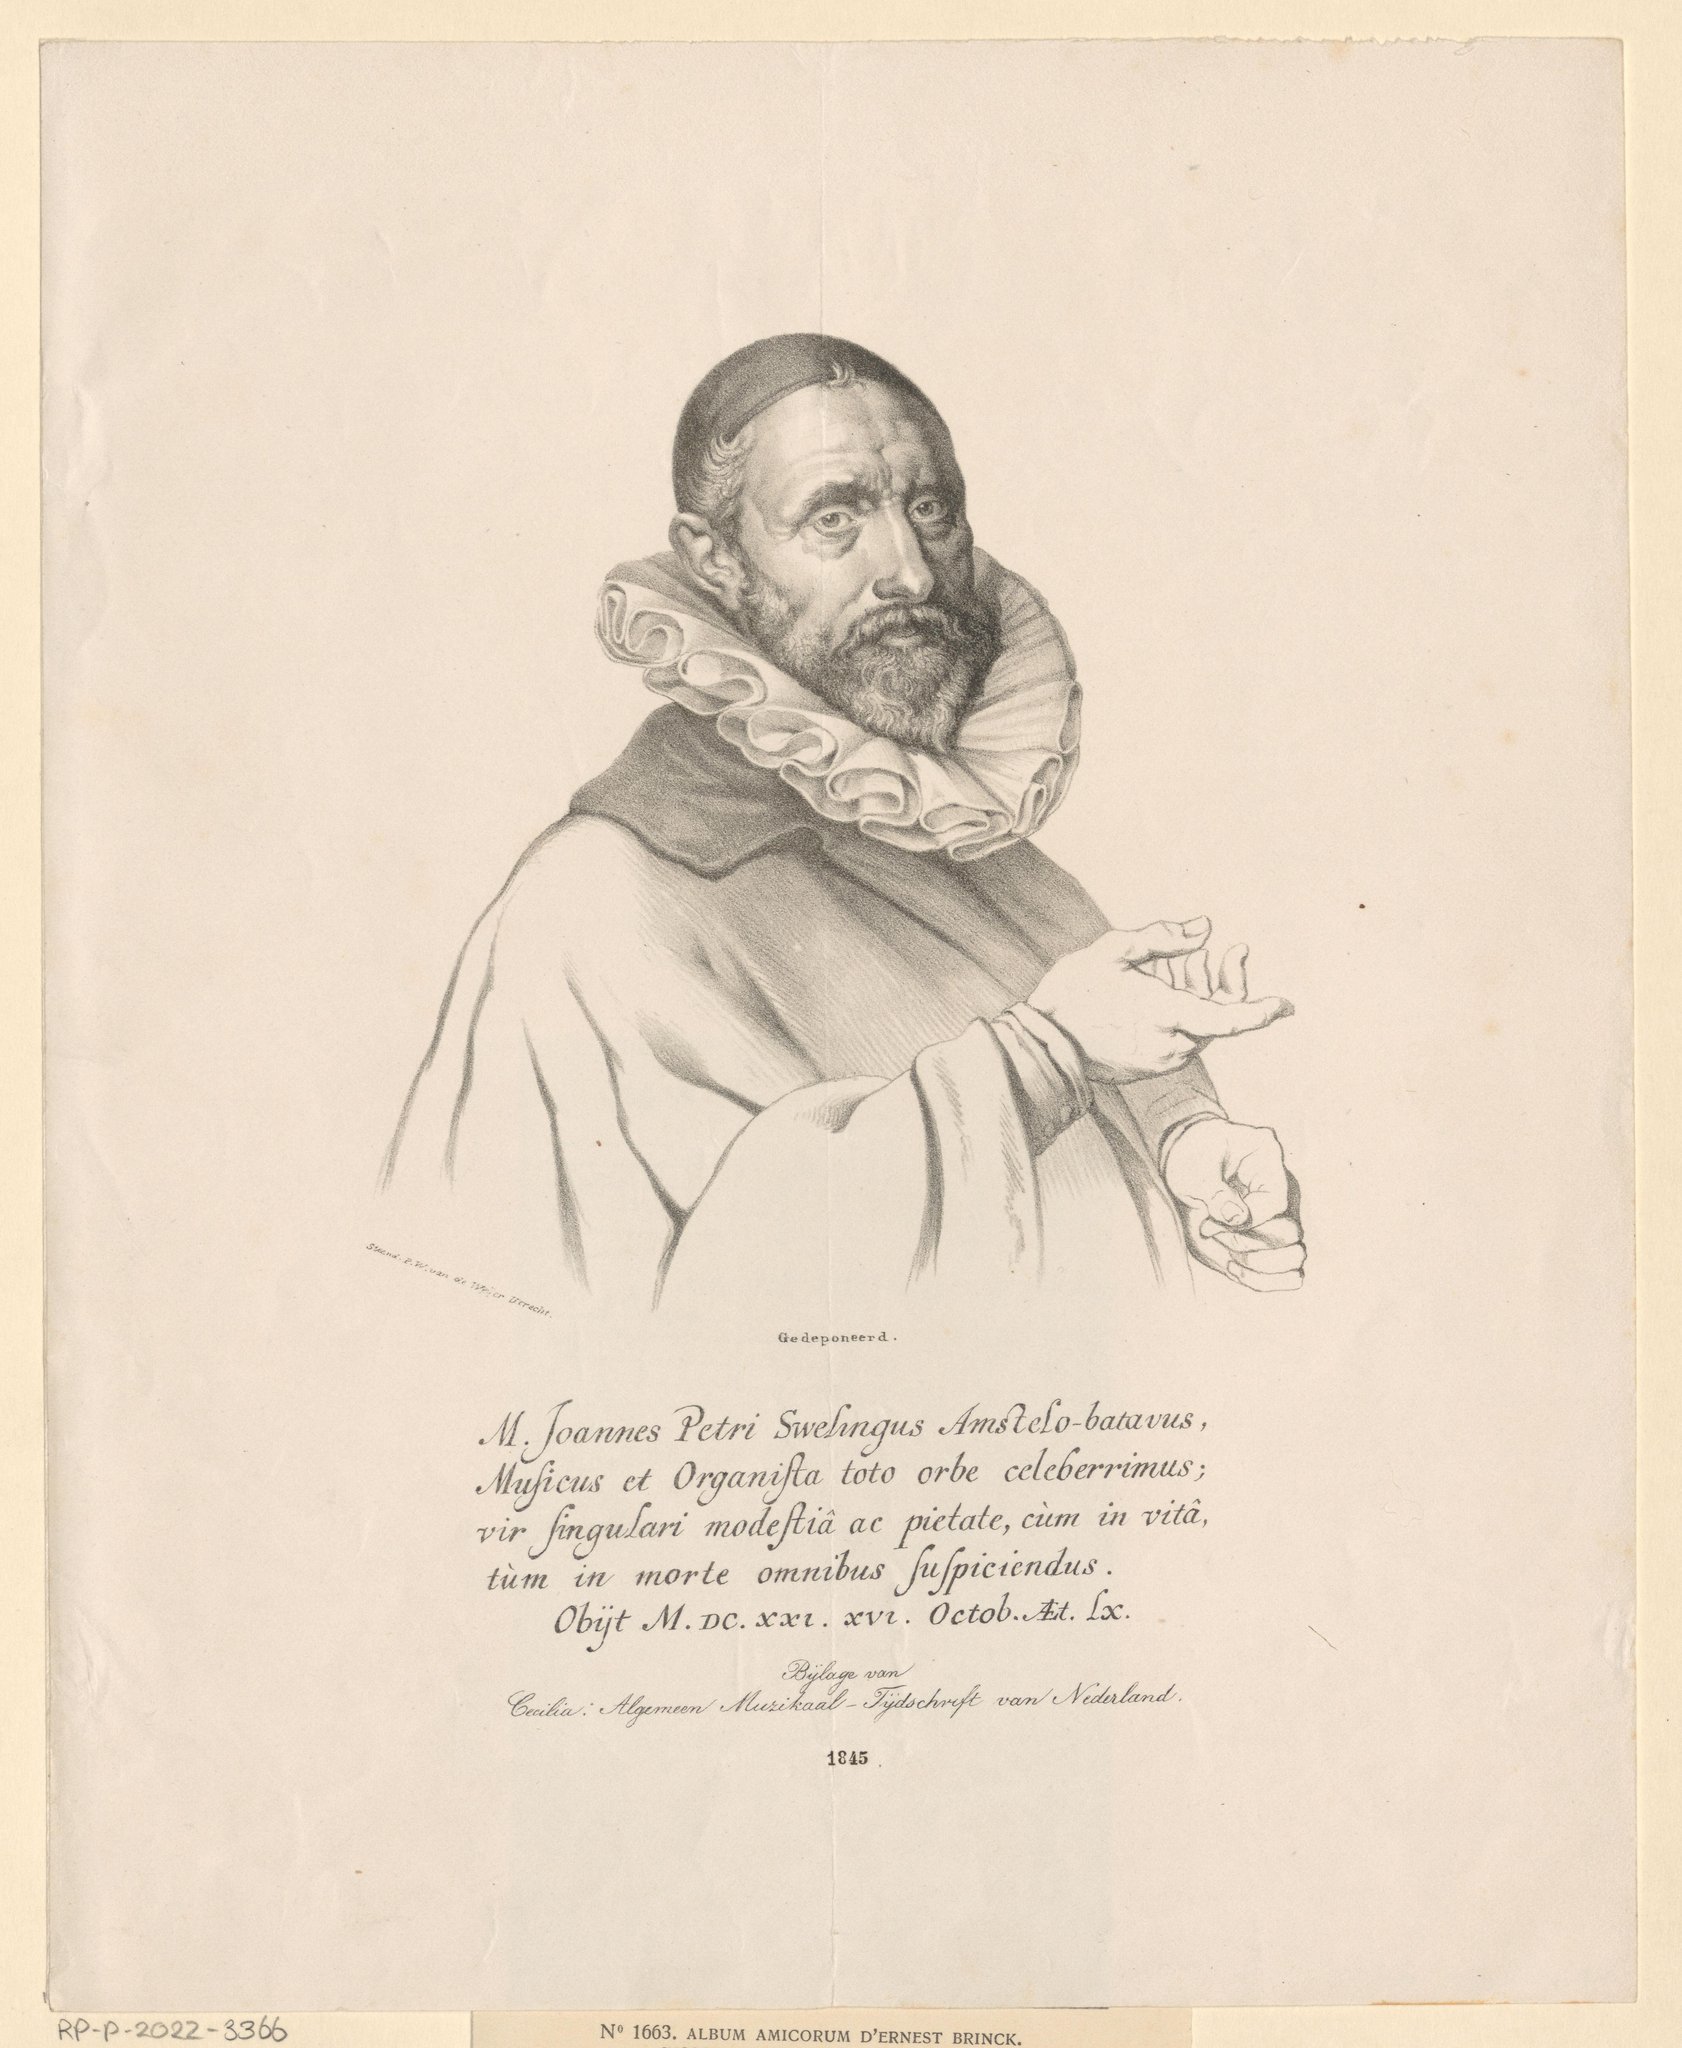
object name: print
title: Portret van Jan Pieterszoon Sweelinck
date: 1845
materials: paper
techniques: lithograph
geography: netherlands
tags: deventer, amsterdam, historical persons, portrait of a musician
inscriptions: : ‘Gedeponeerd.’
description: Prent uitgegeven als bijlage van: Cecilia: Algemeen Muzikaal Tijdschrift van Nederland, 1845.